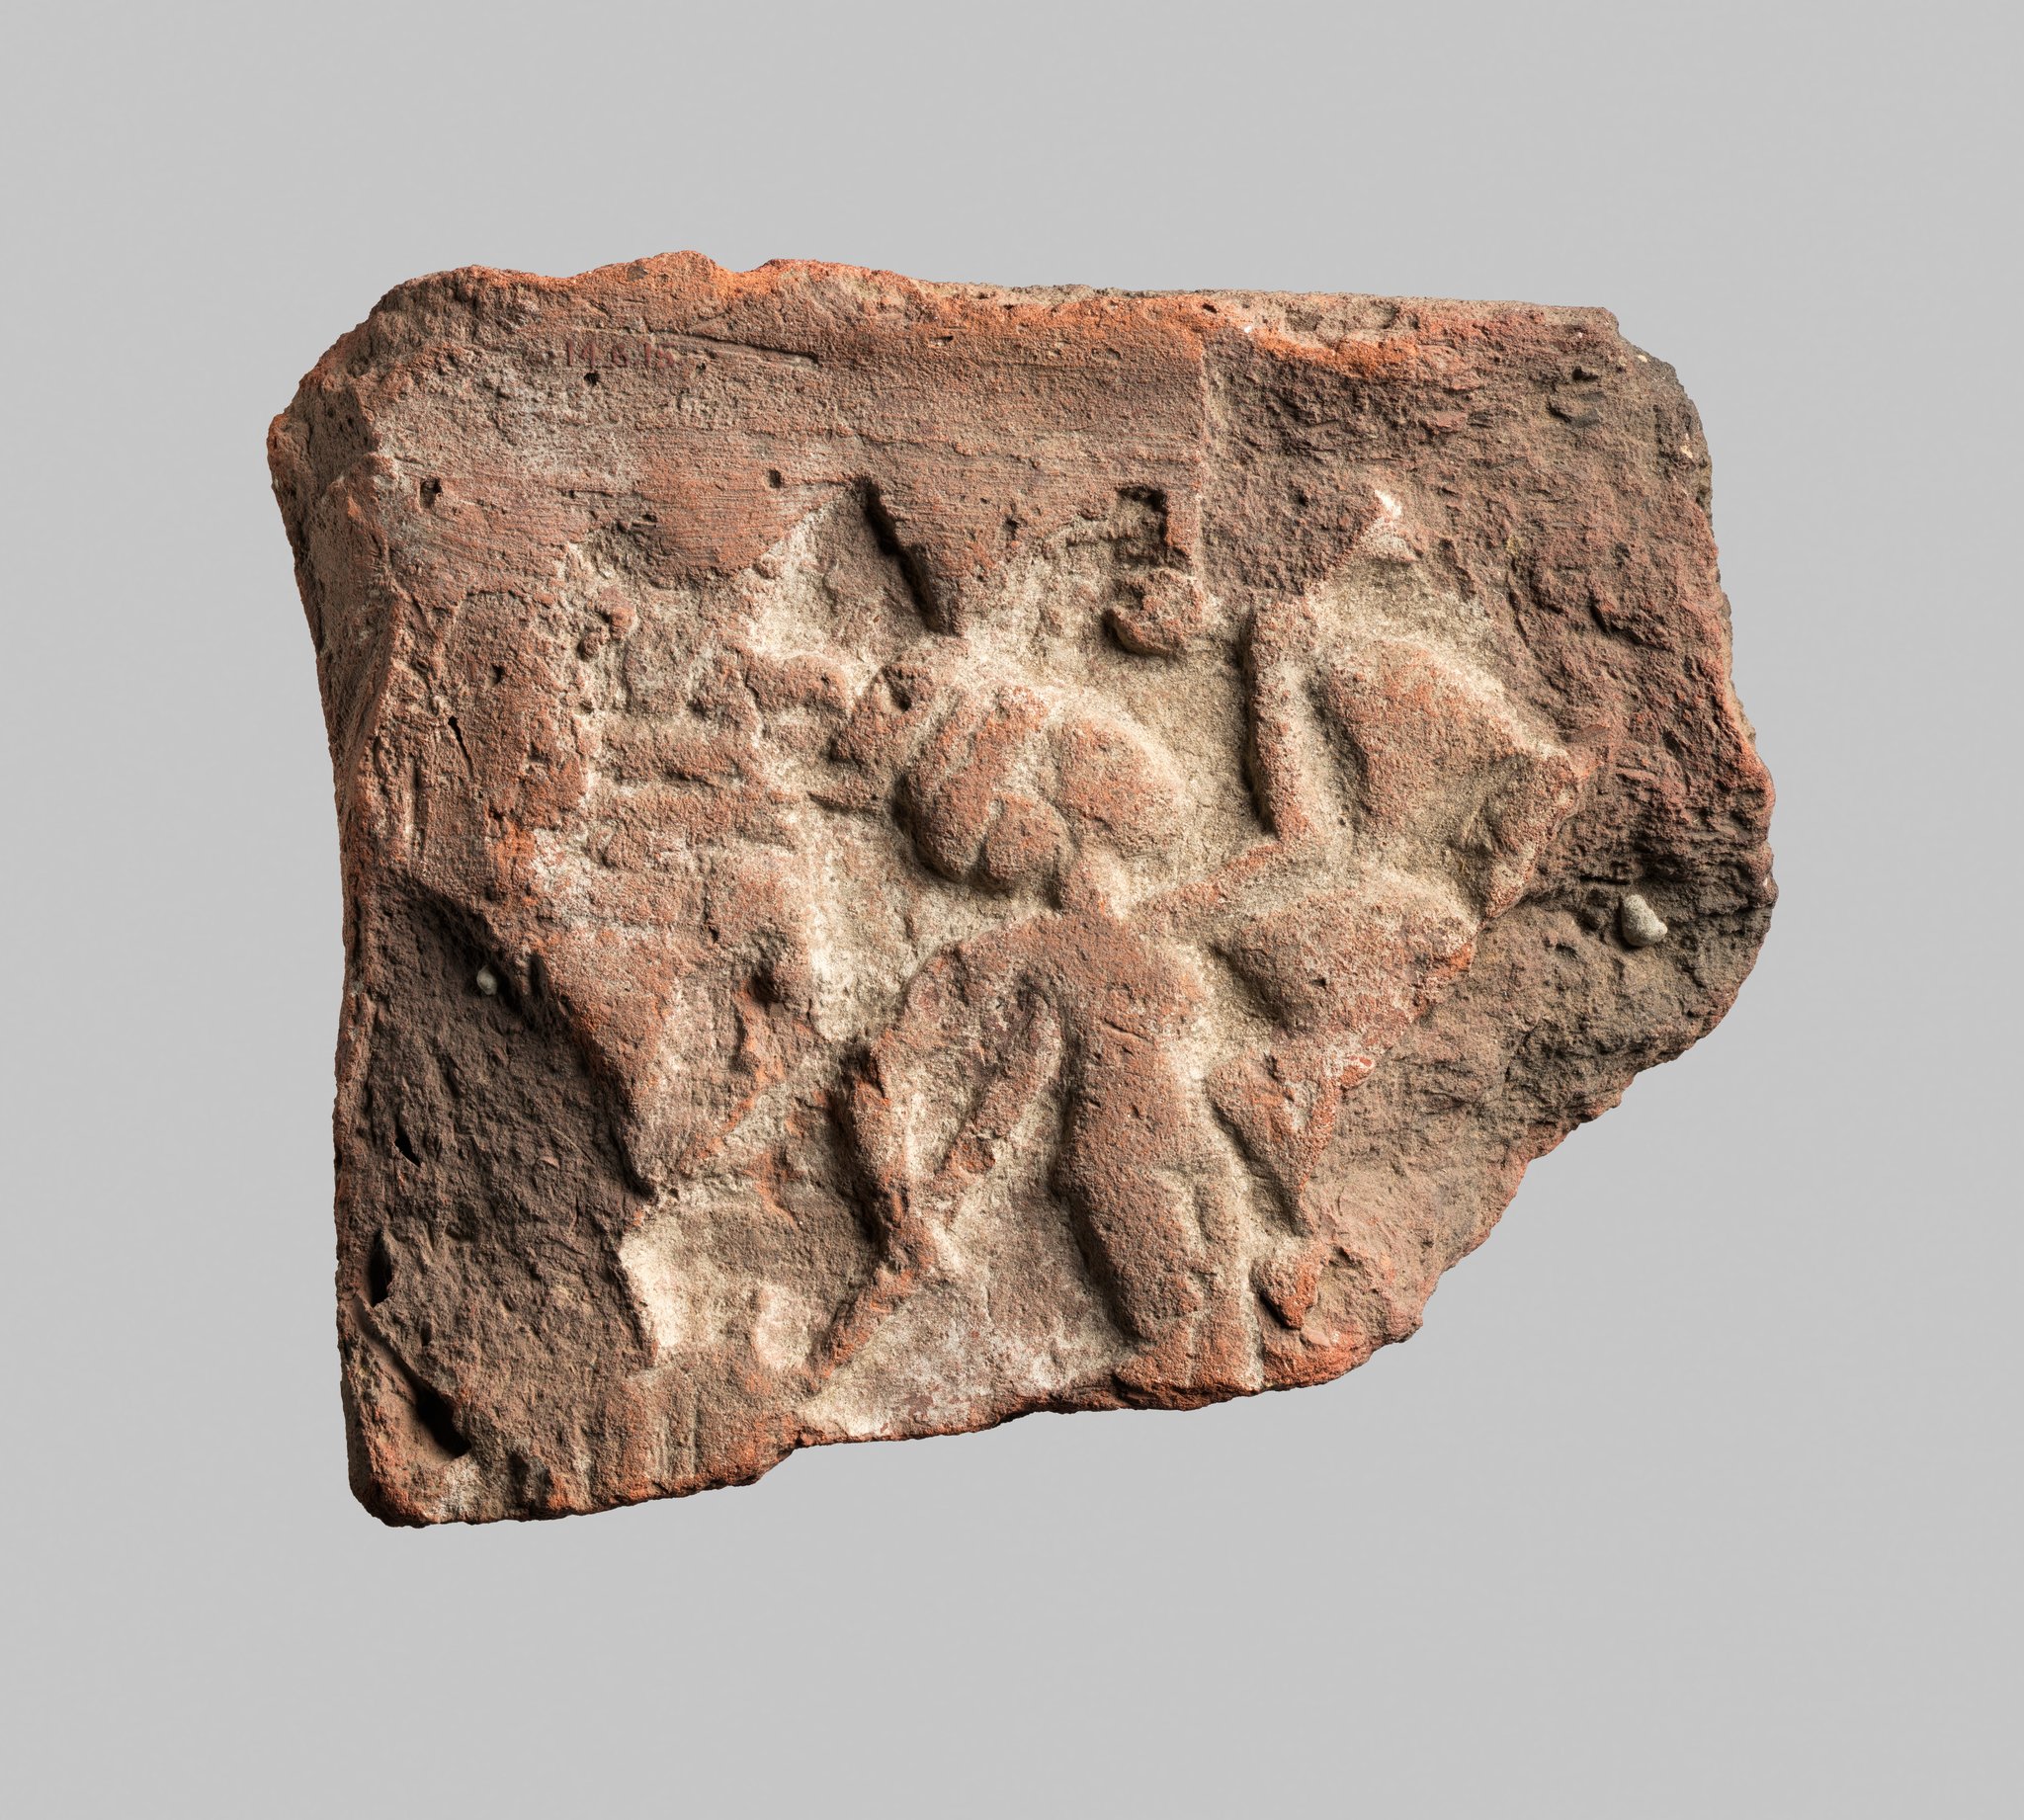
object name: brick, stela fragment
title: Stela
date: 665-650 BCE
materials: pottery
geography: egypt